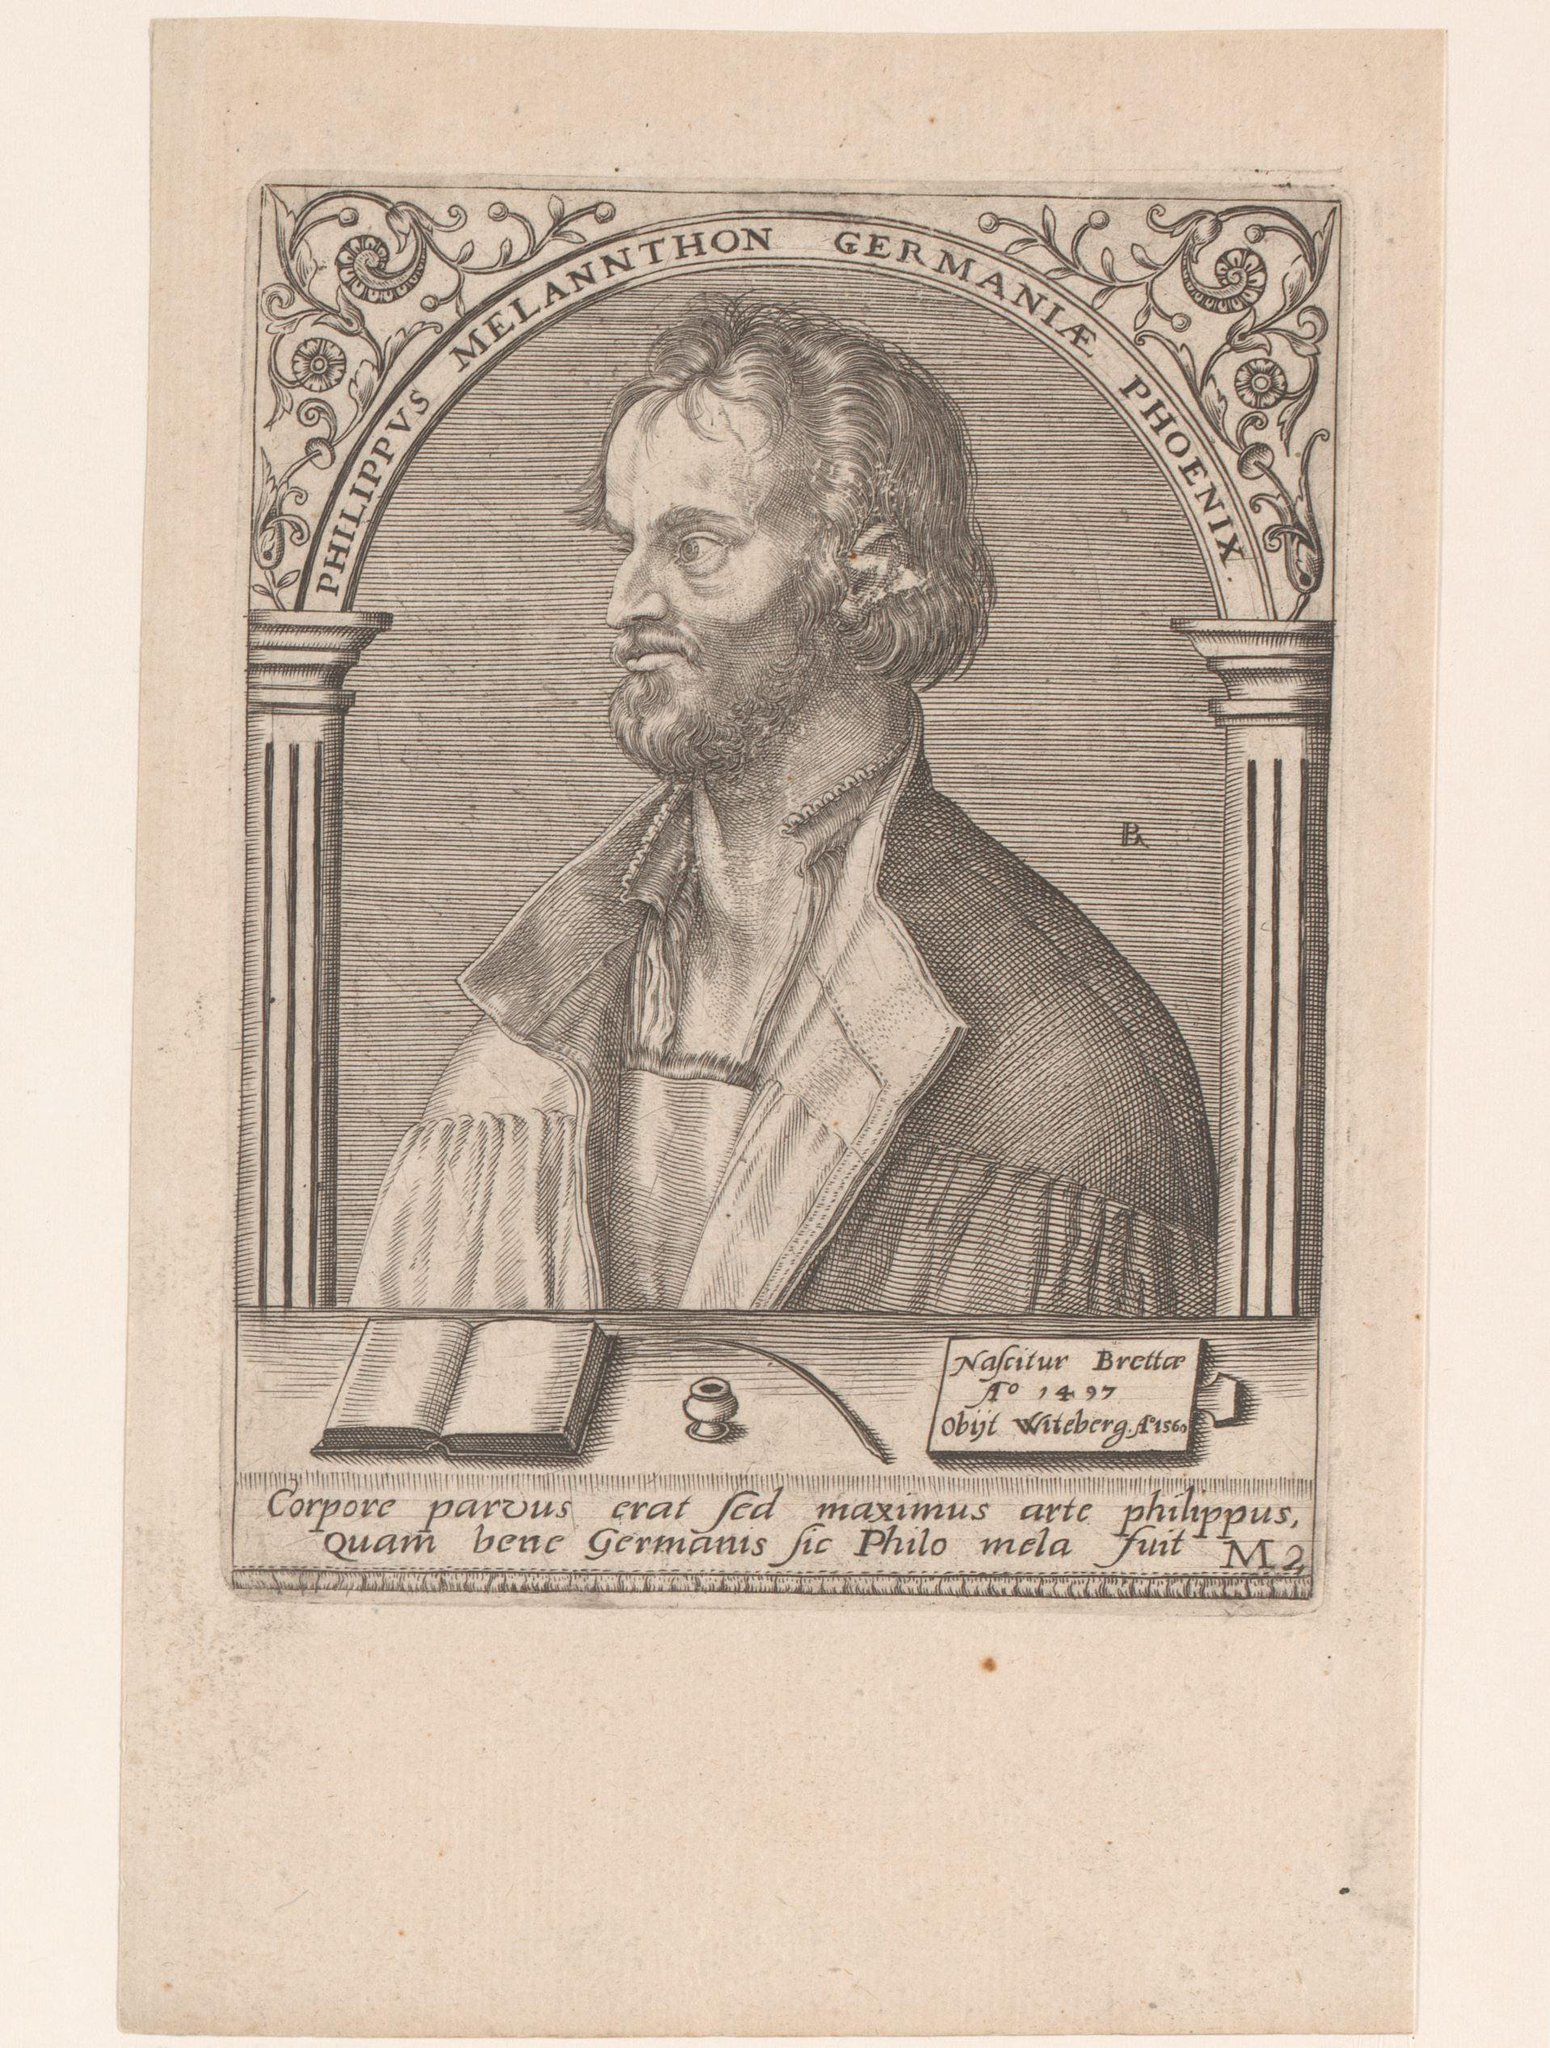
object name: print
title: Serie portretten van vijftiende- en zestiende-eeuwse geleerden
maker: robert boissard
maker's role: print maker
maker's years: 1570-1611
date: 1597-1599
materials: paper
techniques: engraving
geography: france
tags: ink-well, historical persons, book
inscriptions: collector's mark: Lugt 2228